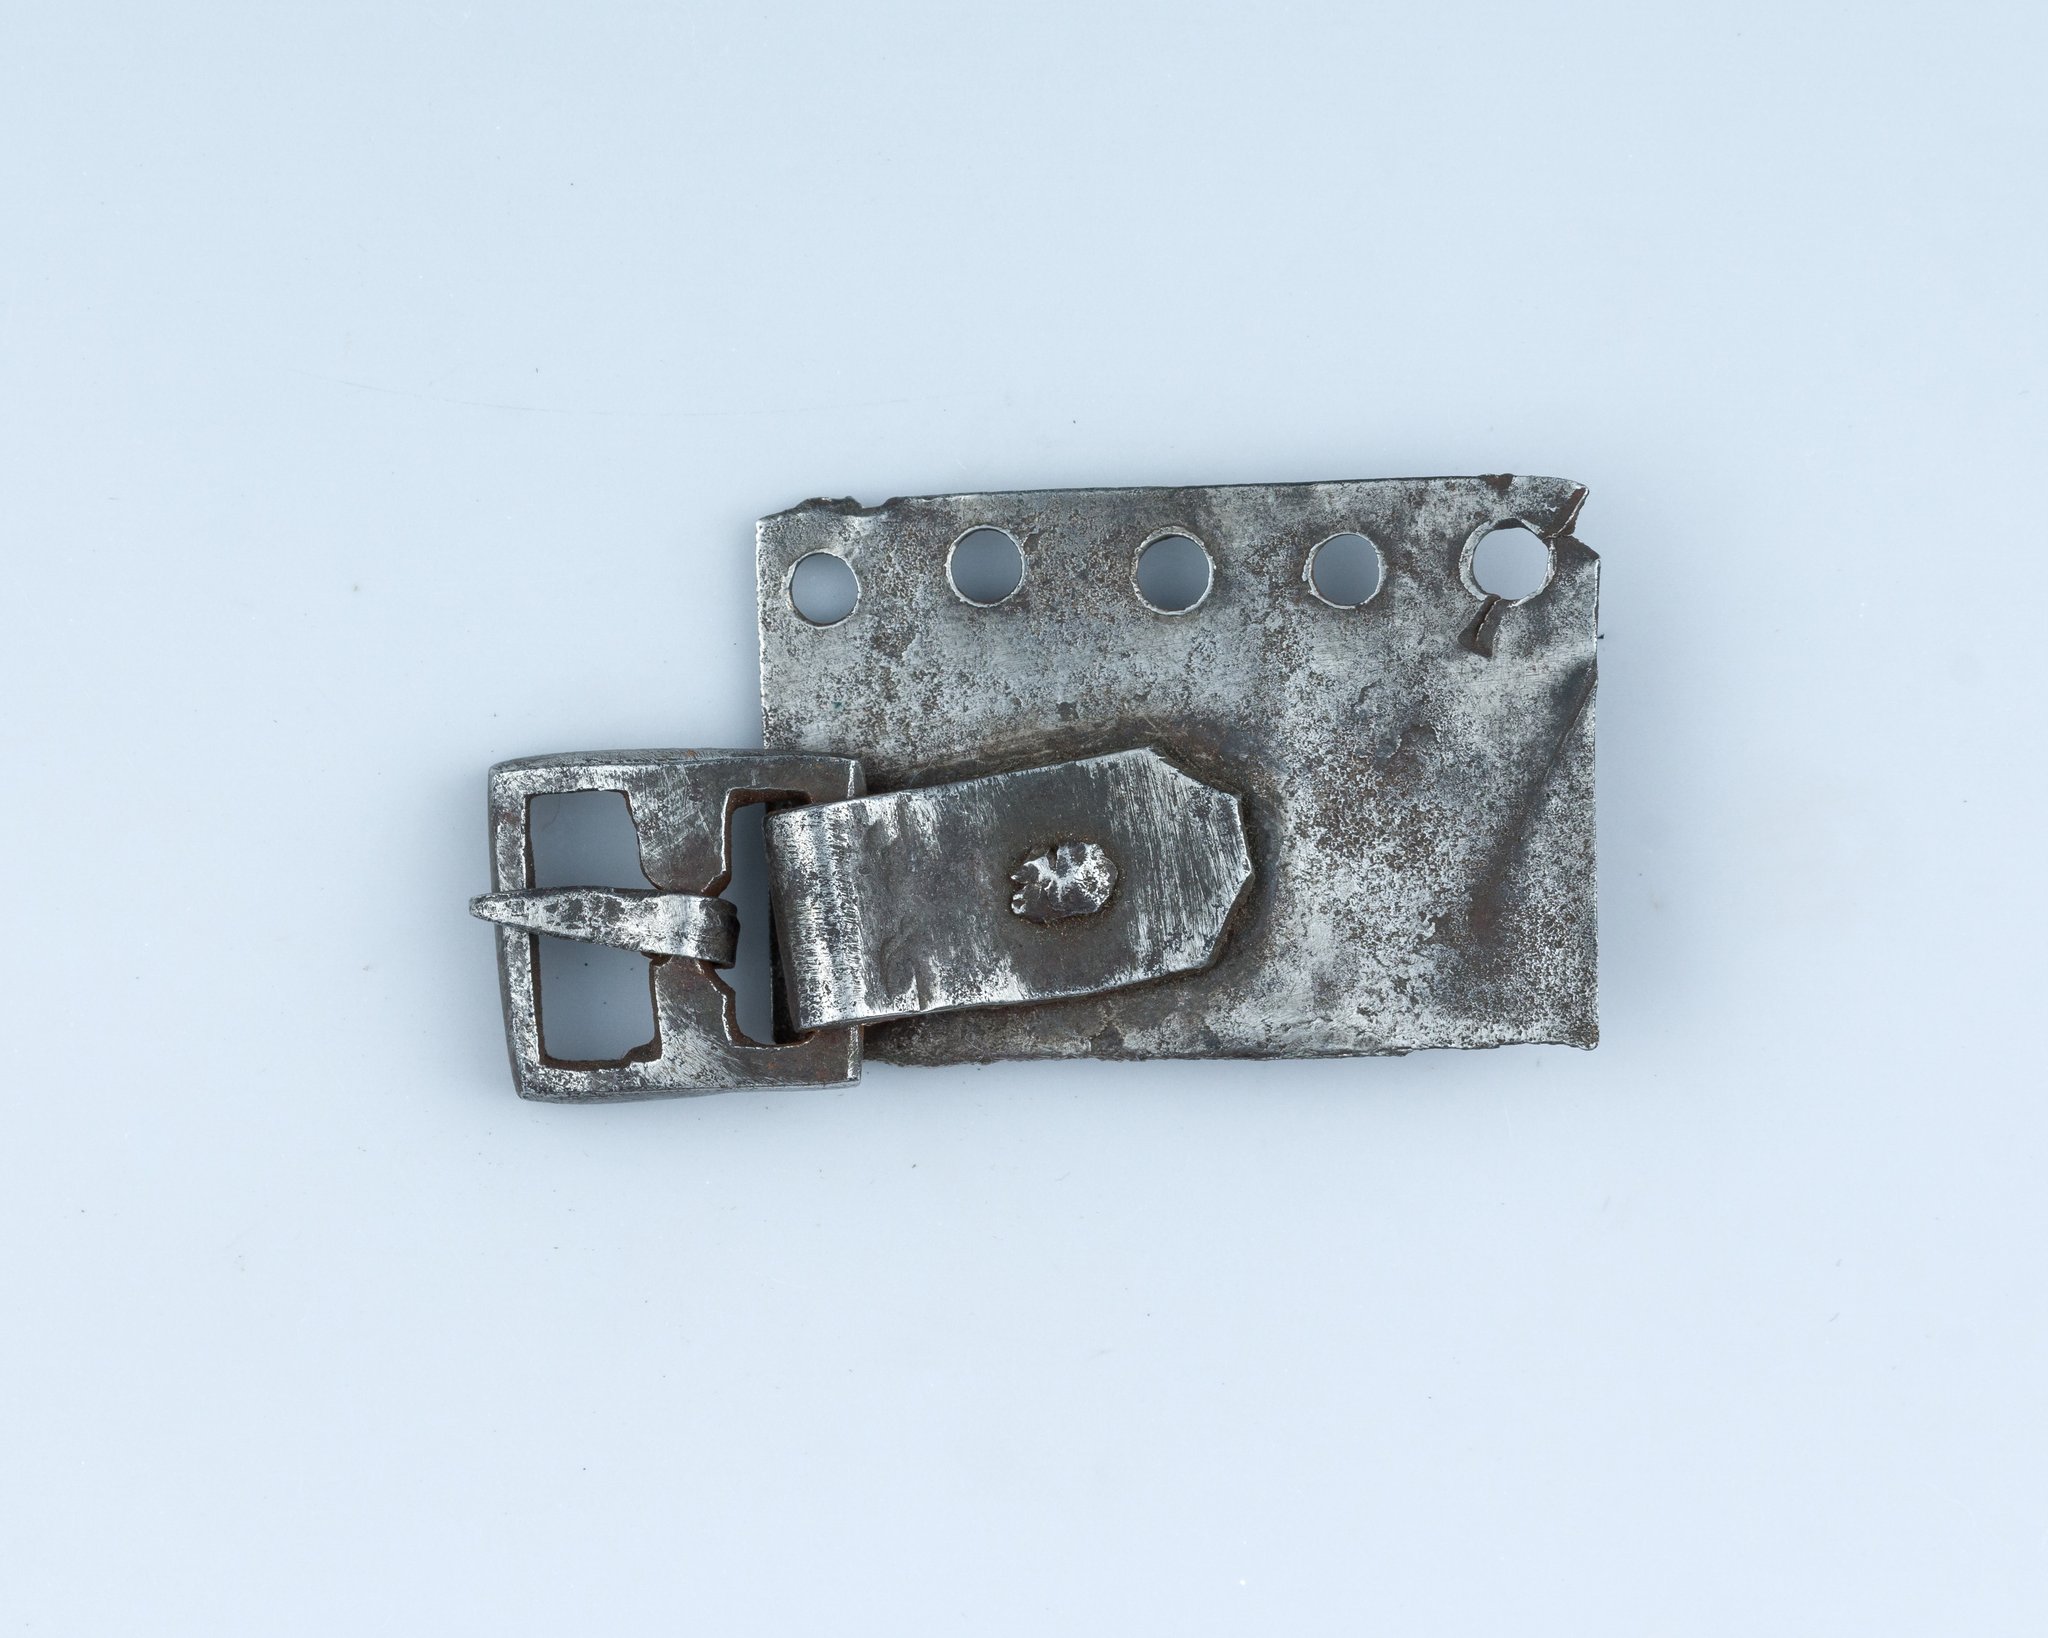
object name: buckle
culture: european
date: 1401-1700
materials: steel